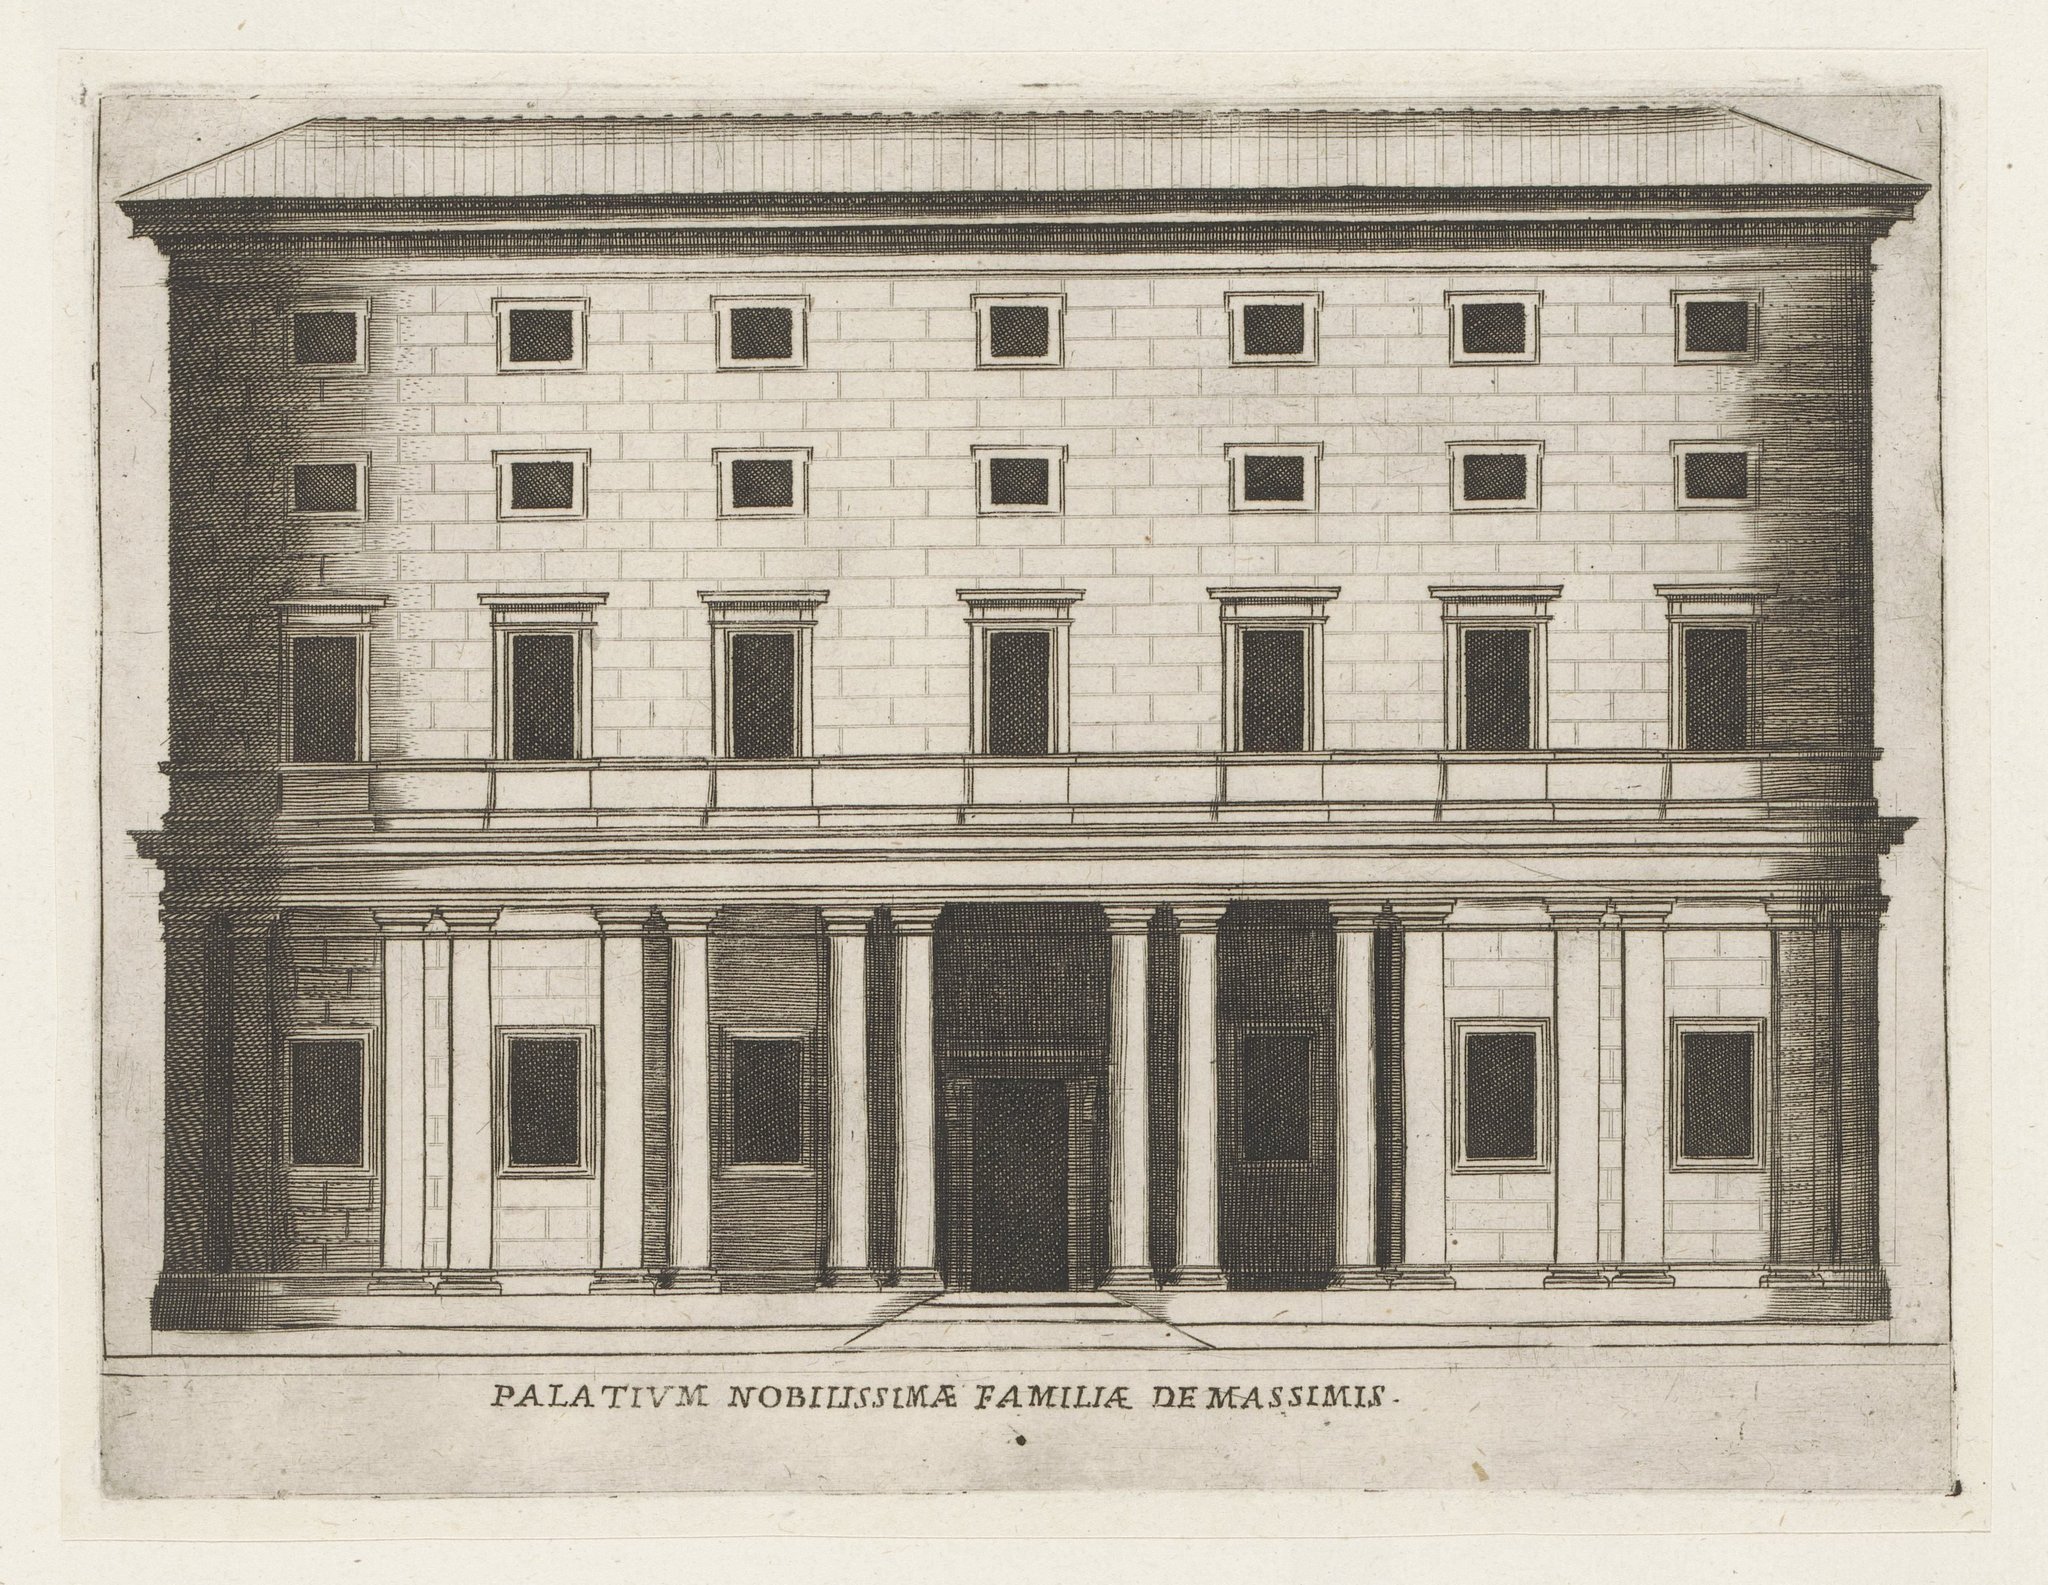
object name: print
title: Magesyn der Italiaense gebouwen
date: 1638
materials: paper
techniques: etching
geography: rome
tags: hôtel, i.e. small palace in city, façade (of house or building)